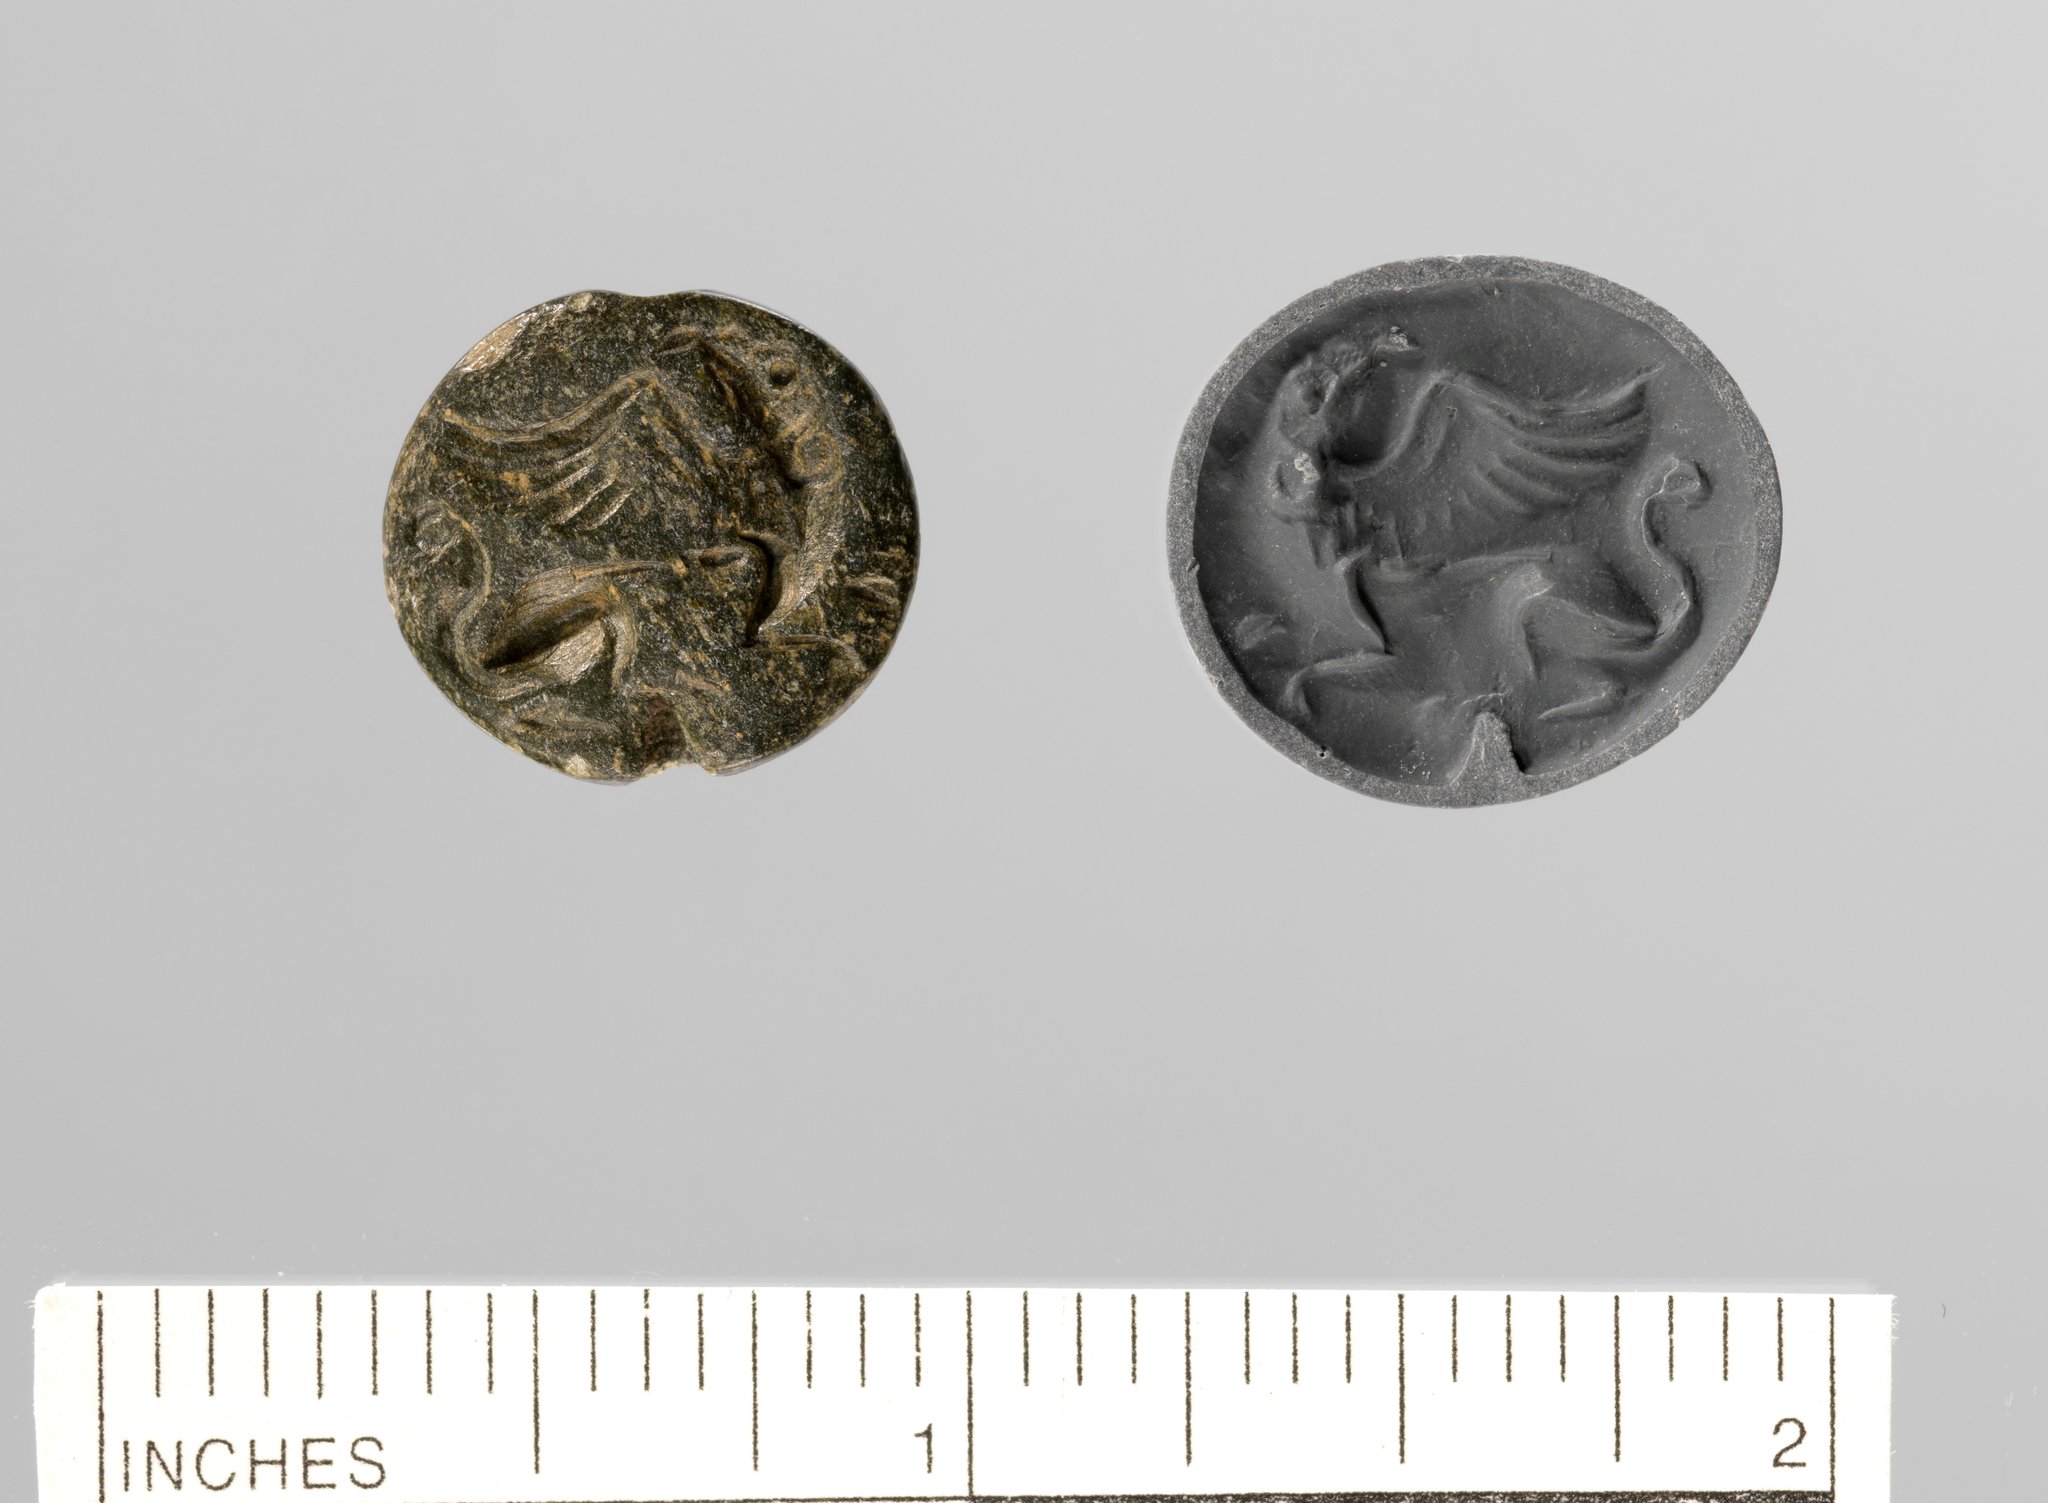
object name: seal, lentoid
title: Steatite Lentoid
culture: minoan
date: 1400-1375 BCE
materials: stone